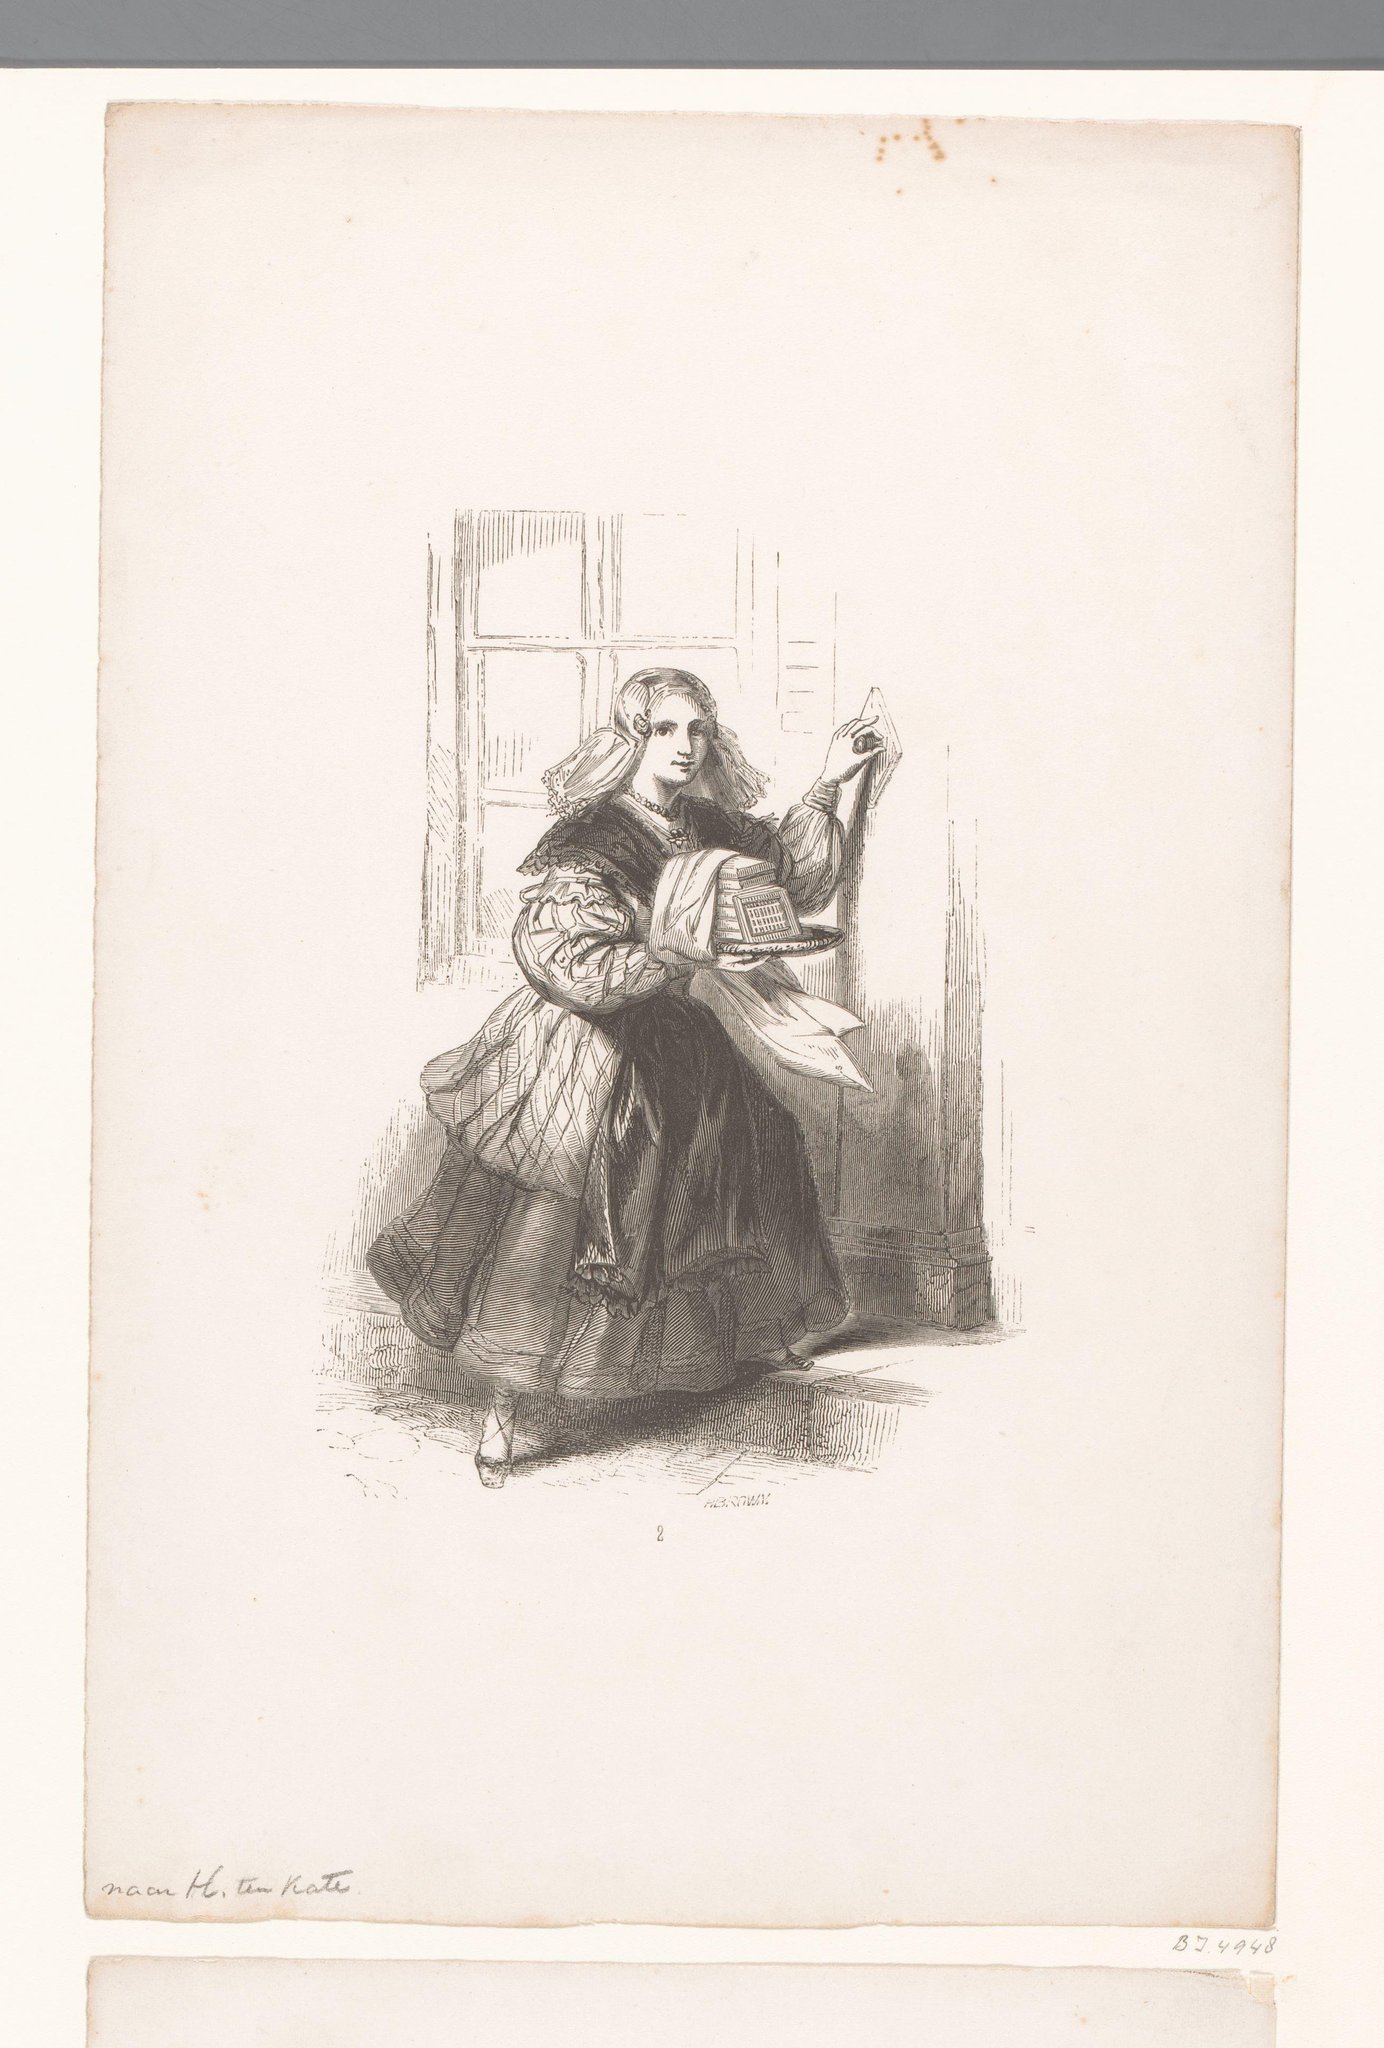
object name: book illustration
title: Meisje met wafels bij een deur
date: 1841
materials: paper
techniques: engraving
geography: the hague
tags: adolescent, young woman, maiden, waffles, selling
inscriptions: collector's mark: Lugt 2228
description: Prent uit: Brown, Henry. De Nederlanden: karakterschetsen, kleederdragten, houding en voorkomen van verschillende standen. Den Haag: Nederlandsche Maatschappij van Schoone Kunsten, 1841.